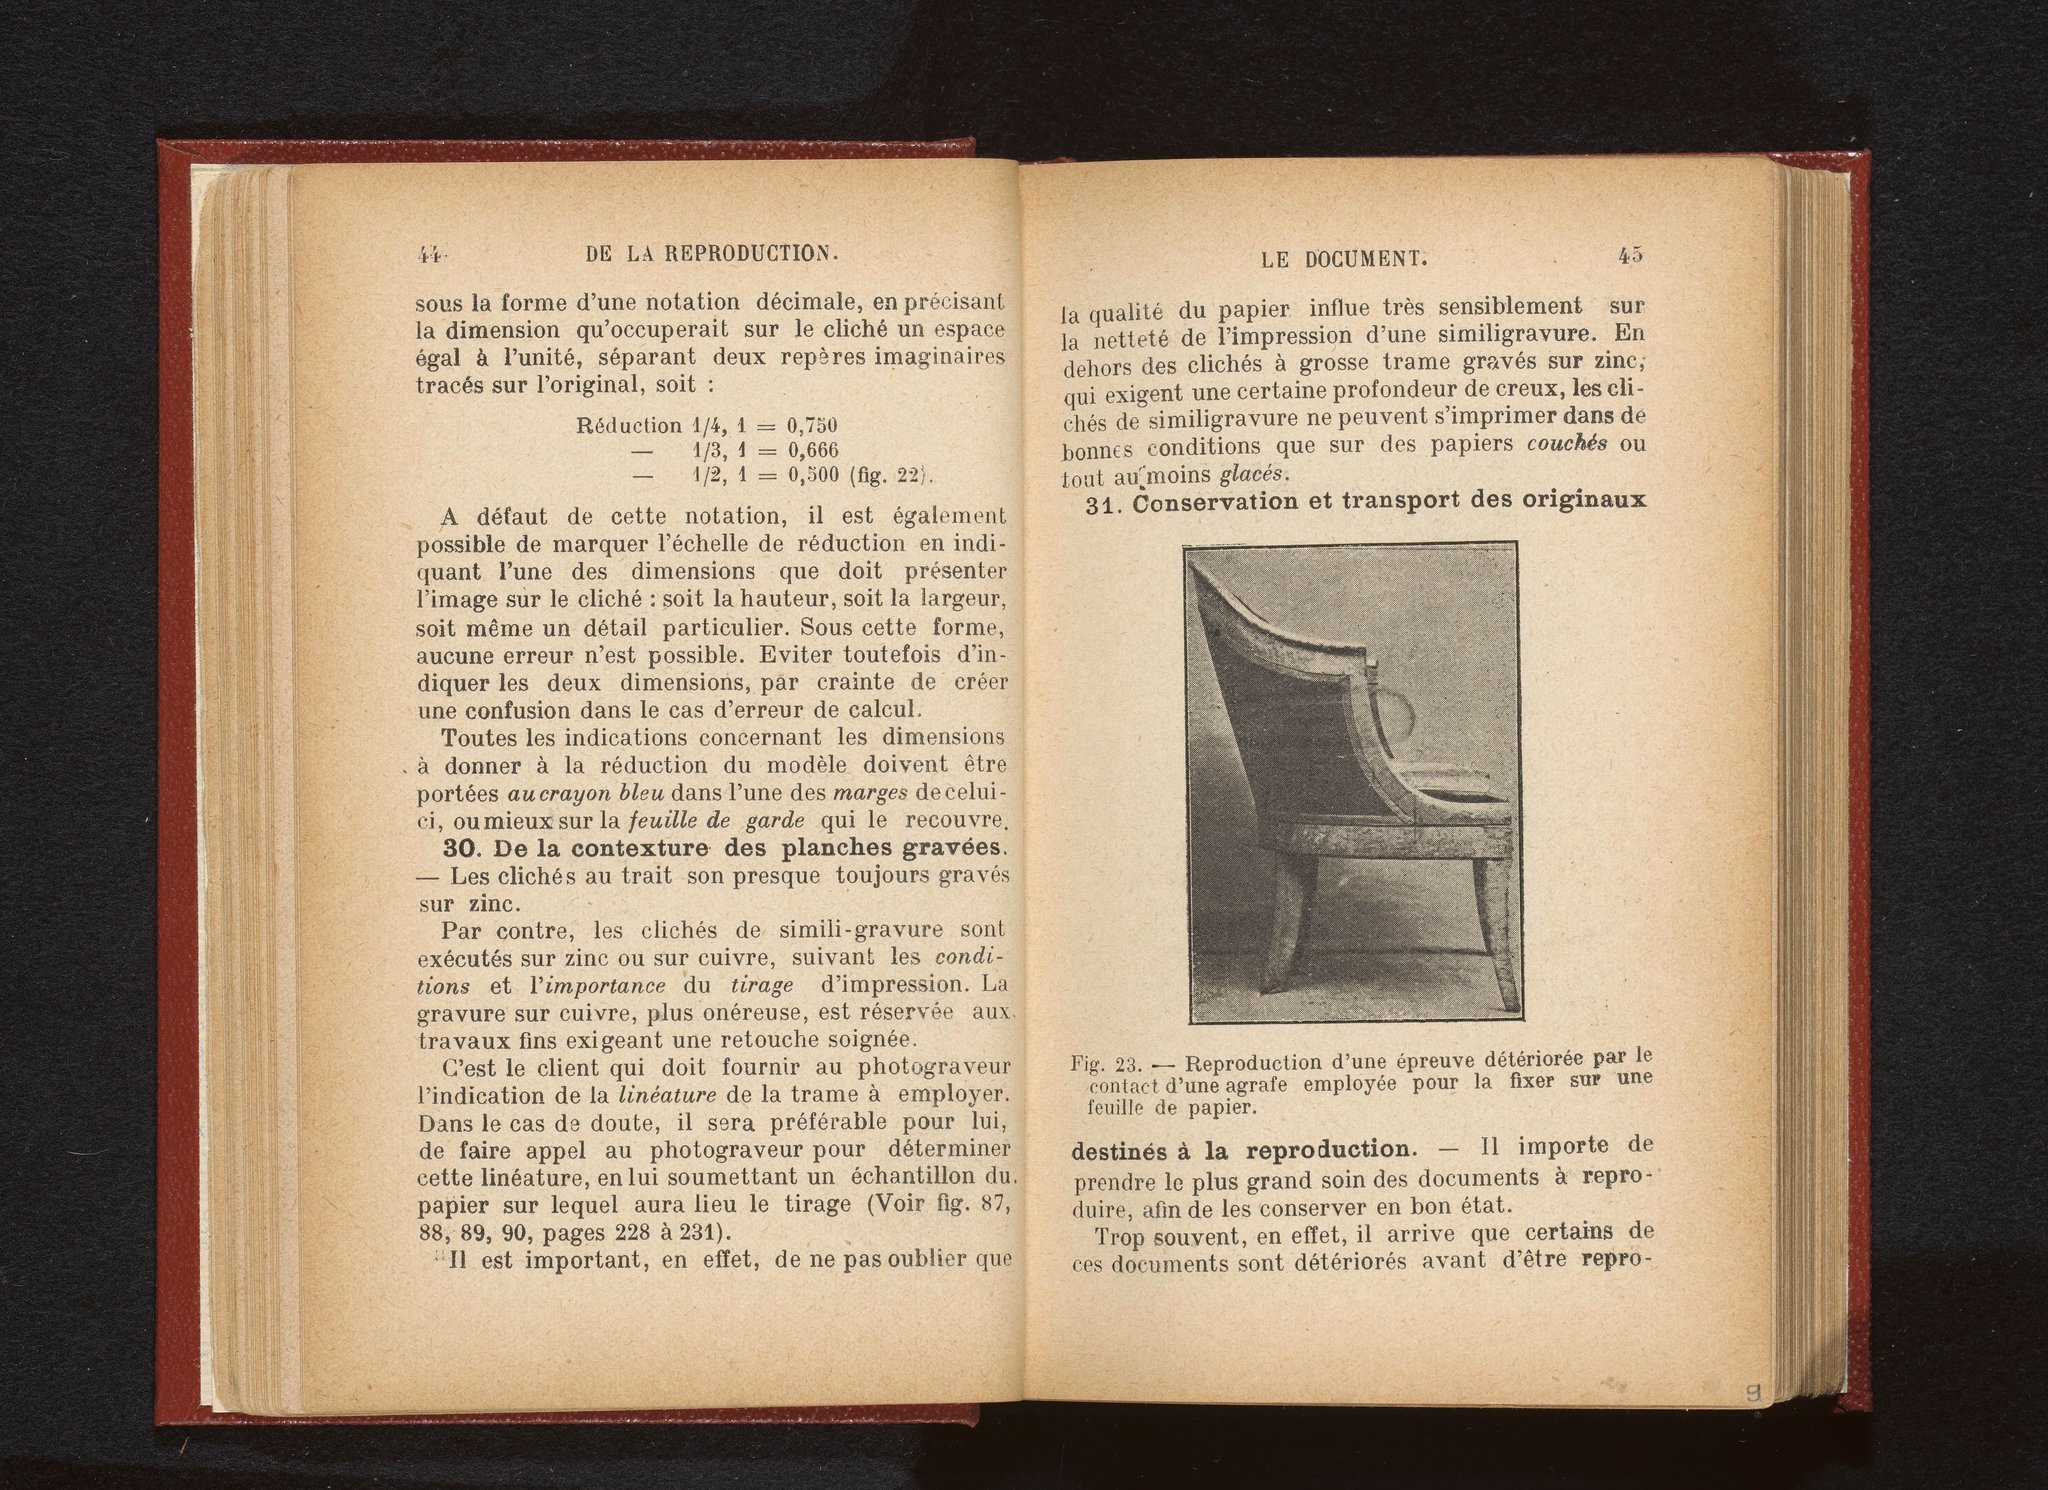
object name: photomechanical print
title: Reproduction d'un épreuve détériorée par le contact d'un agrafe employée pour la fixer sur une feuille de papier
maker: Anonymous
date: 1922-1932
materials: paper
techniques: autotype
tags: chair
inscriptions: number: ‘Fig. 23.’